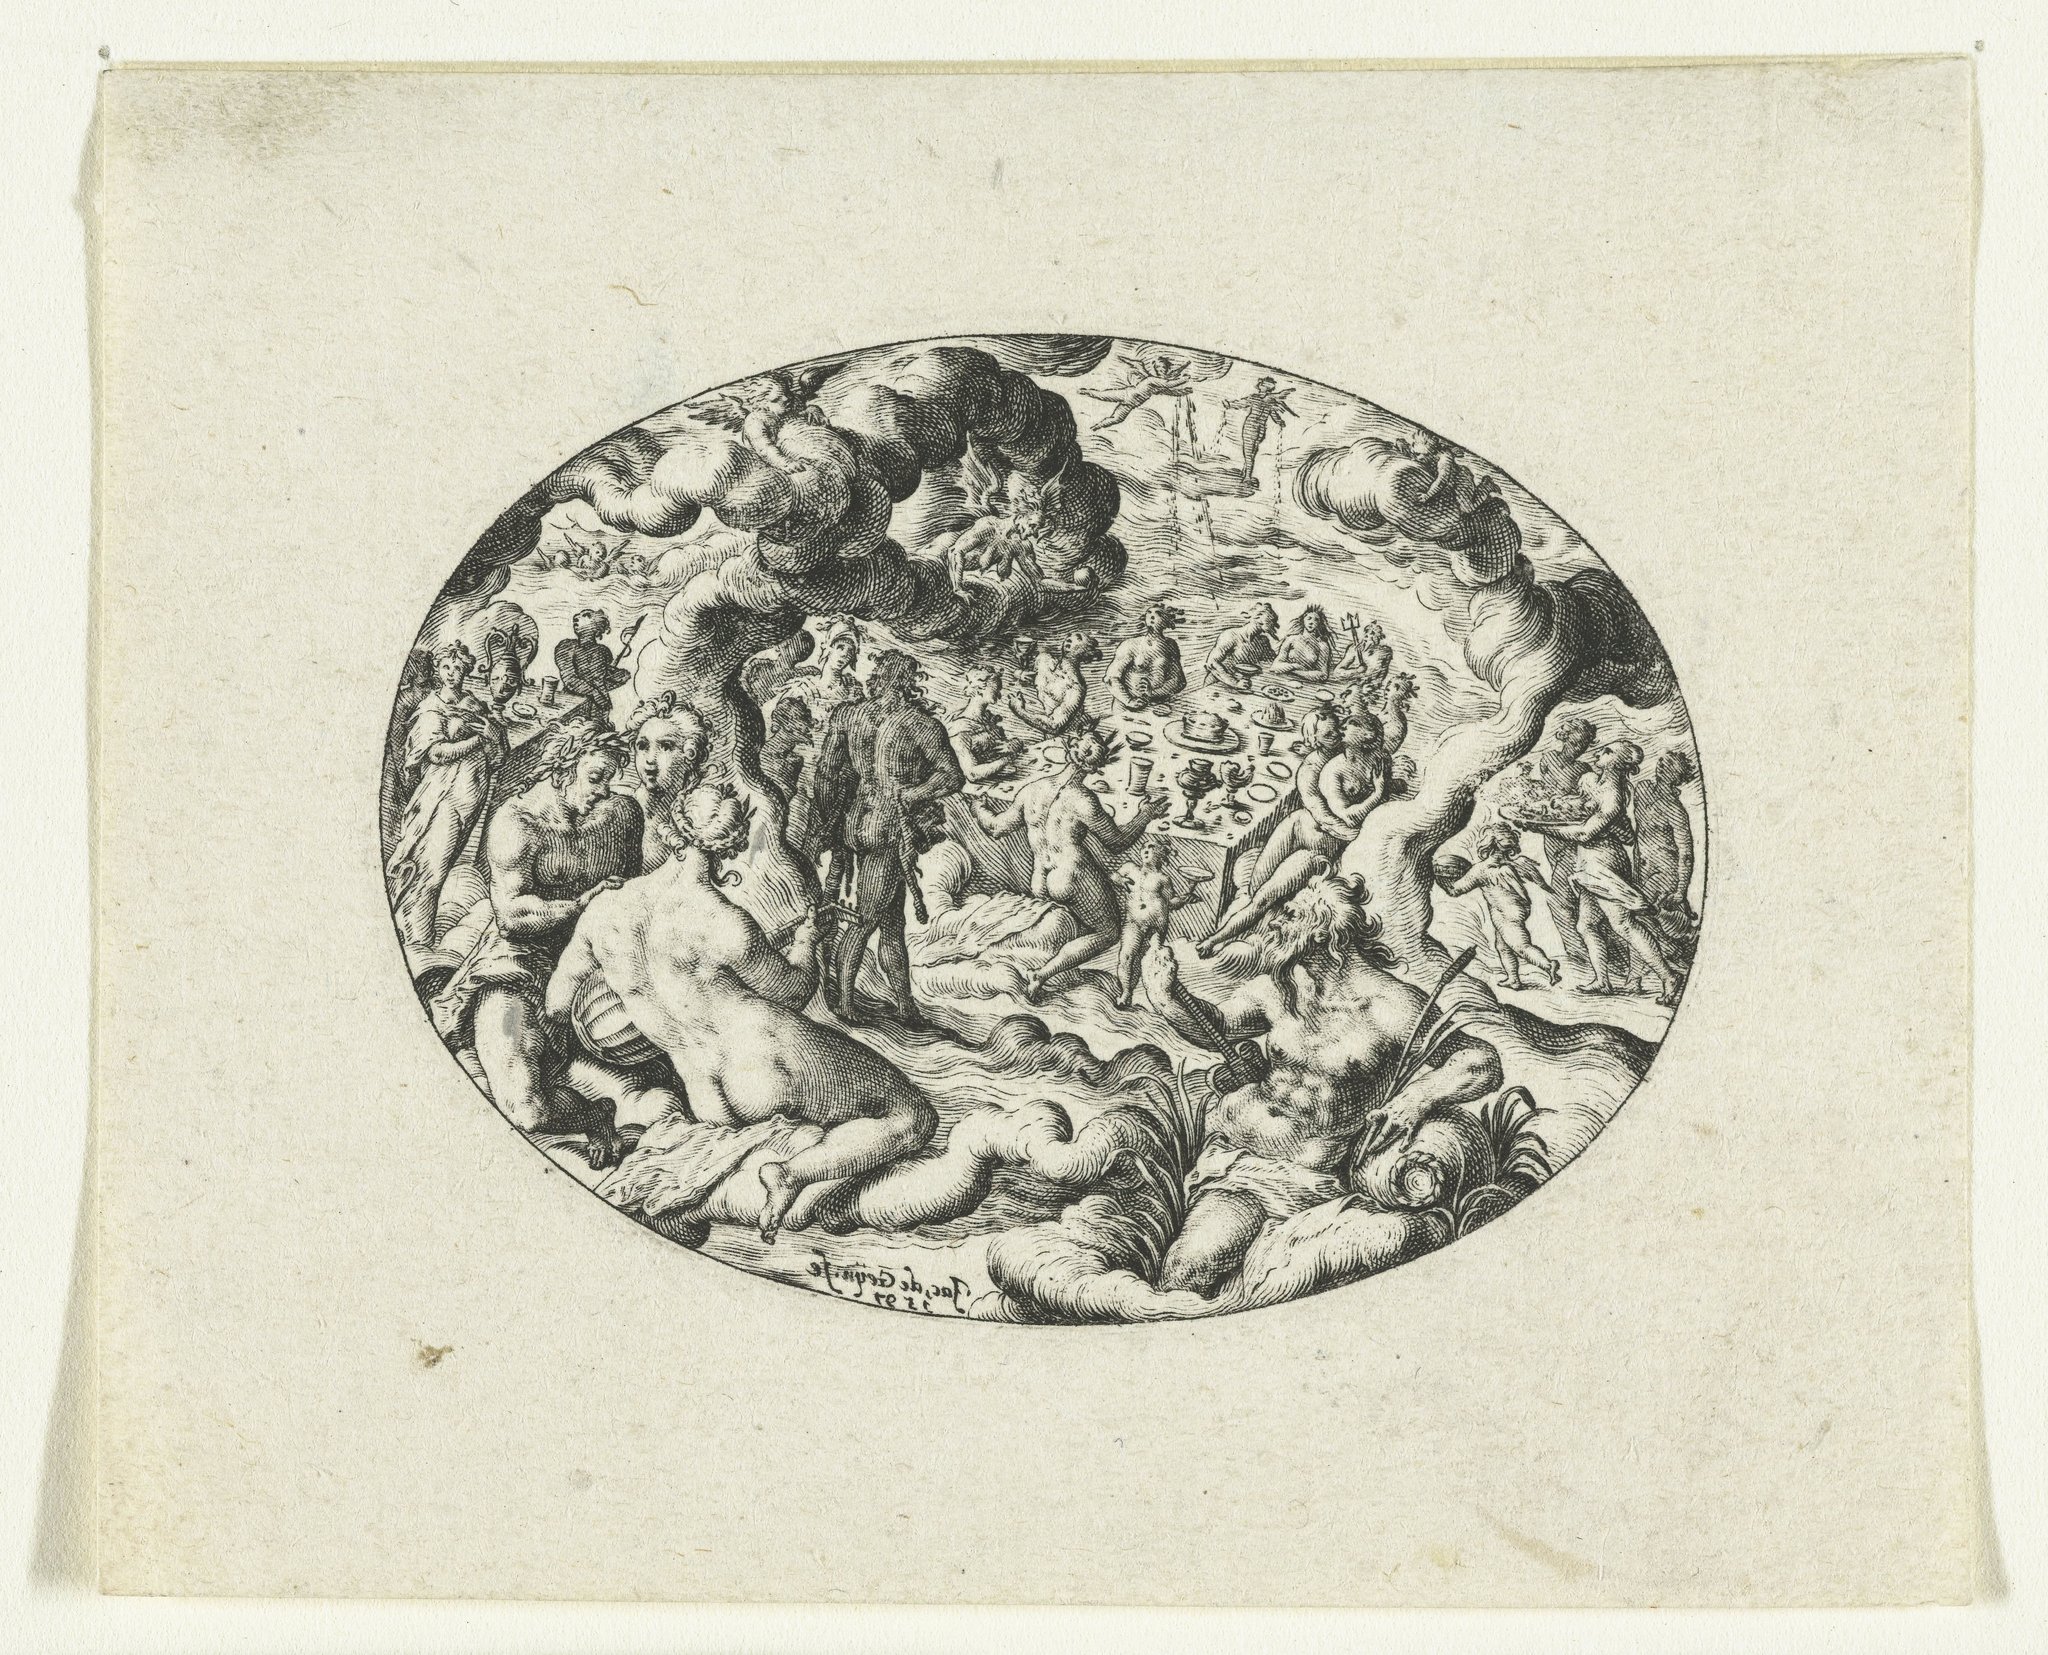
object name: print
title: Godenbanket tijdens de bruiloft van Peleus en Thetis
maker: jacques de gheyn (ii)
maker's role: painter, print maker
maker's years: 1565-1629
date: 1597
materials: paper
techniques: engraving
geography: leiden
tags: the marriage-feast of peleus and thetis in the clouds, eris throws the golden apple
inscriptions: collector's mark: Lugt 240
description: Ovale voorstelling van het huwelijksfeest van Peleus en Thetis. Temidden van de wolken gebruiken godenfiguren aan lange tafels de maaltijd. Op de achtergrond biedt Eris, de godin van de twist, de gouden appel aan de gasten aan.